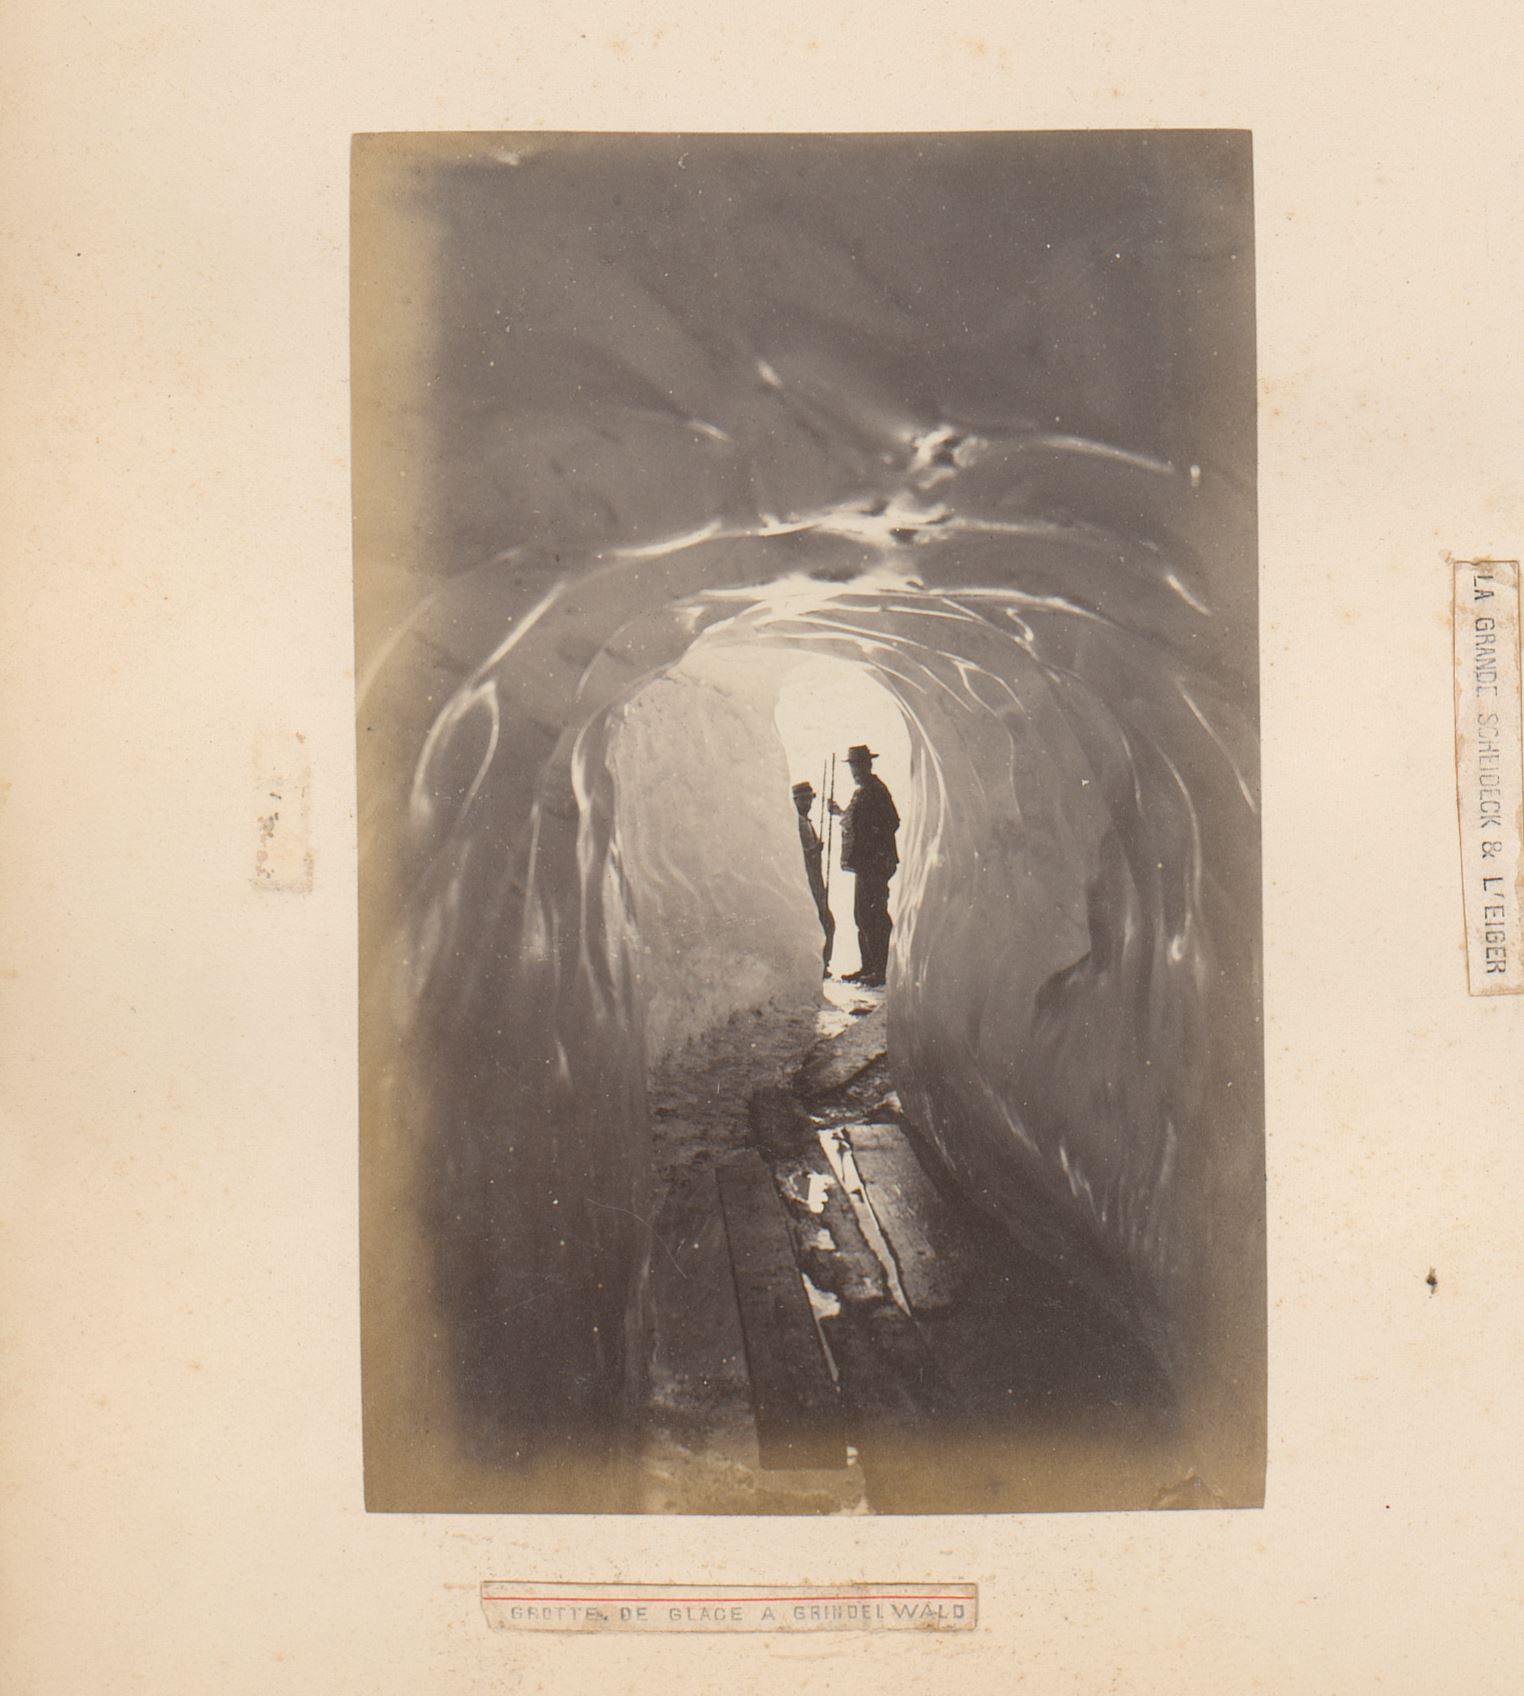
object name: photograph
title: IJsgrot bij Gindelwald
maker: Anonymous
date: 1860-1890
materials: paper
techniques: albumen print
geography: grindelwald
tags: cave, grotto (+ landscape with figures, staffage)